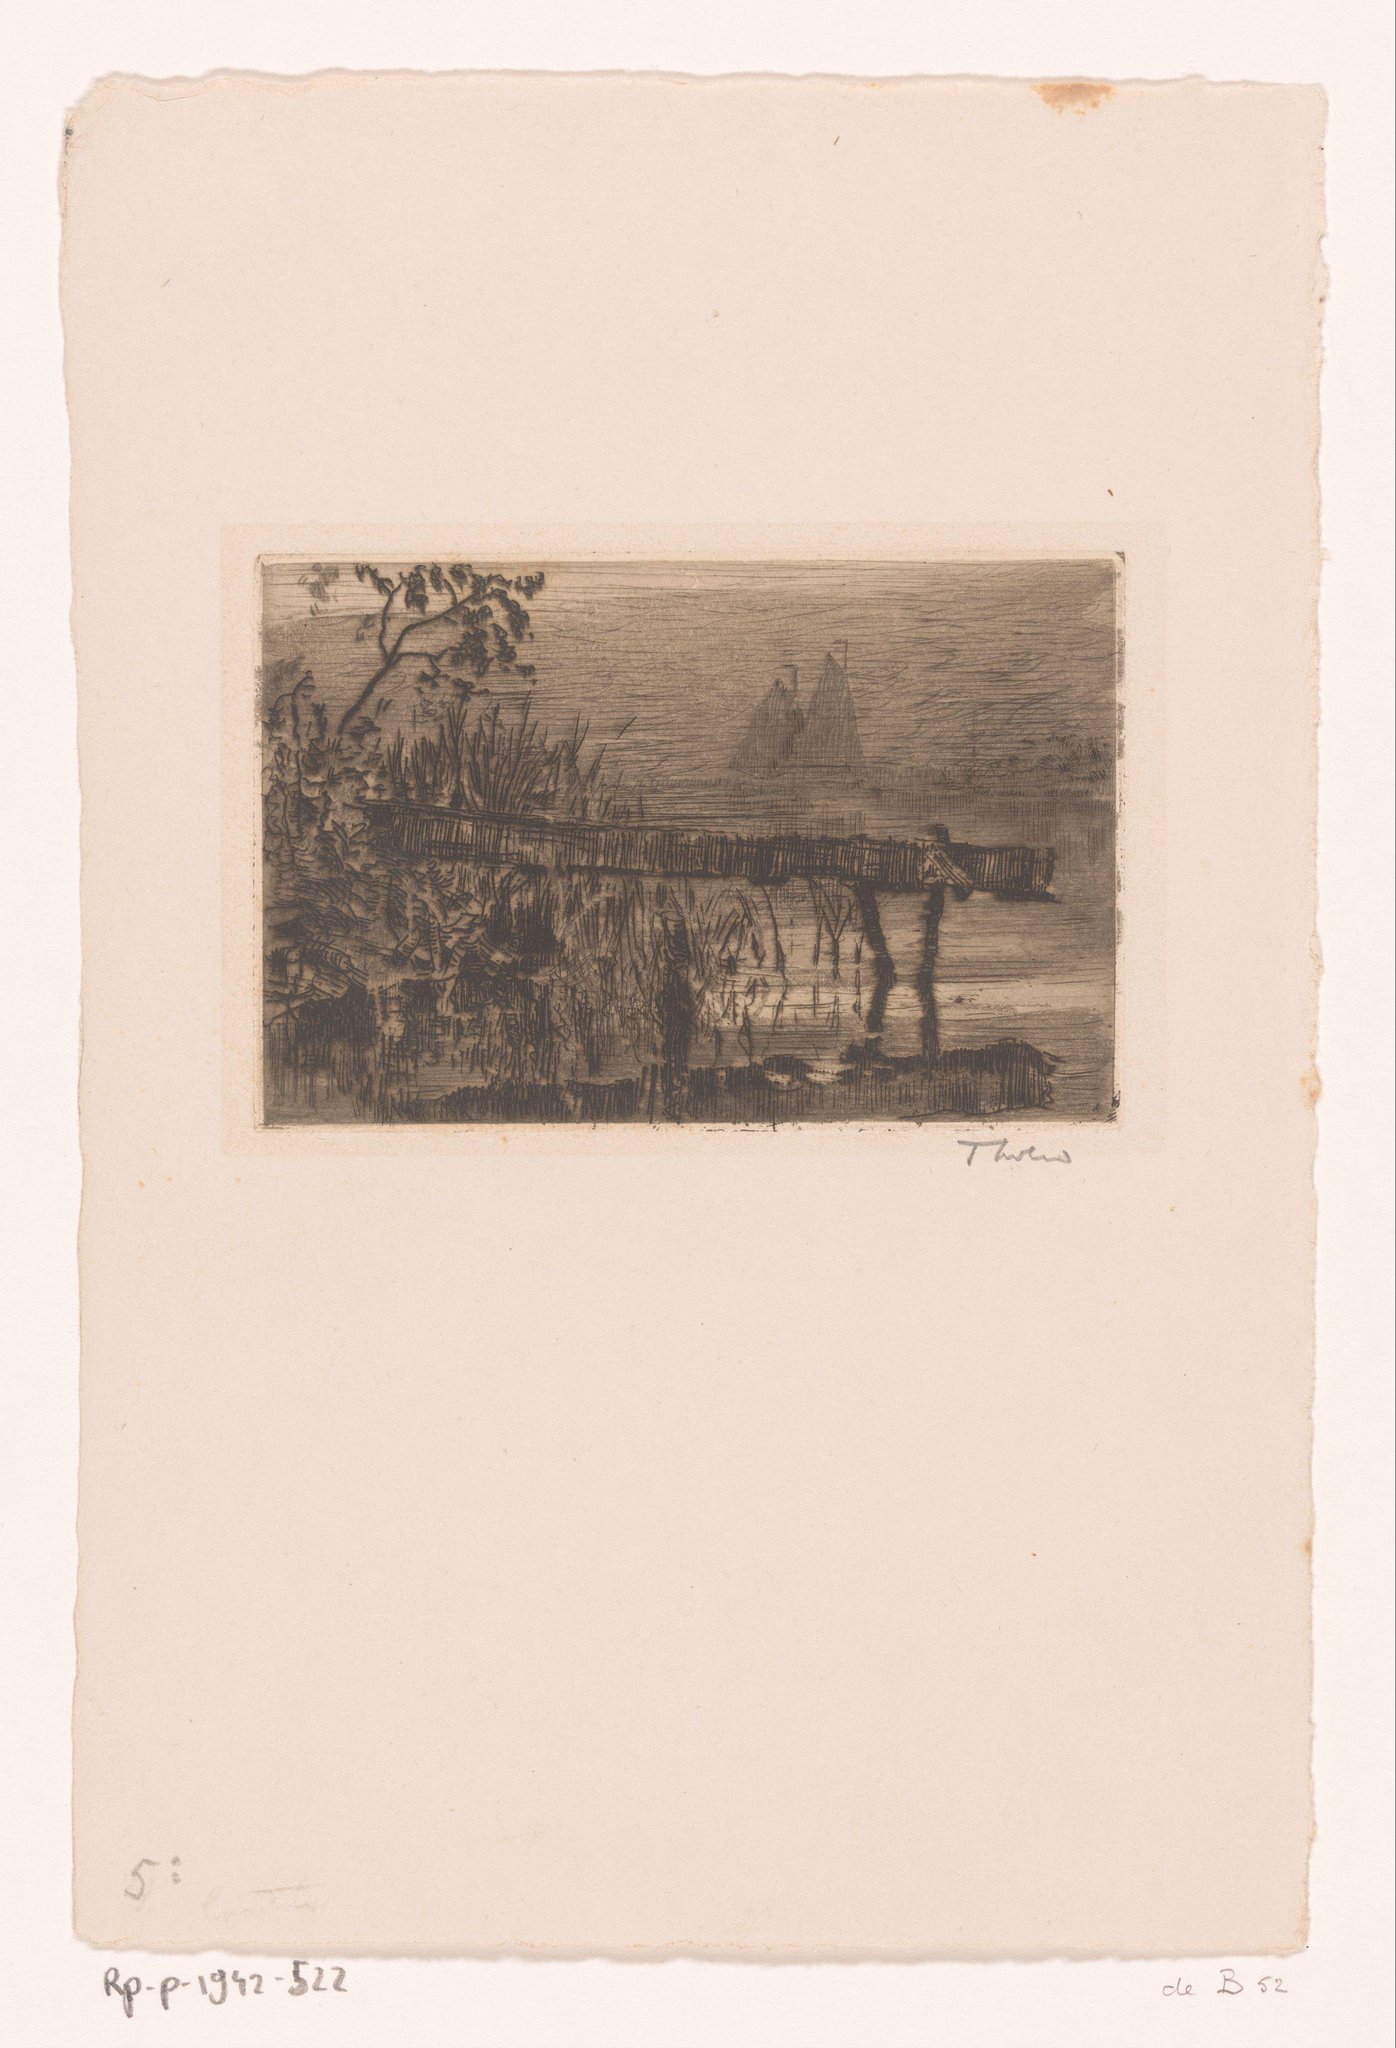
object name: print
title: Donker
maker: willem bastiaan tholen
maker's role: draughtsman, painter, print maker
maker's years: 1860-1931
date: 1870-1914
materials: paper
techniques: aquatint, etching, intaglio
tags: sailing-ship, sailing-boat, lake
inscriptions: collector's mark: Lugt 2228